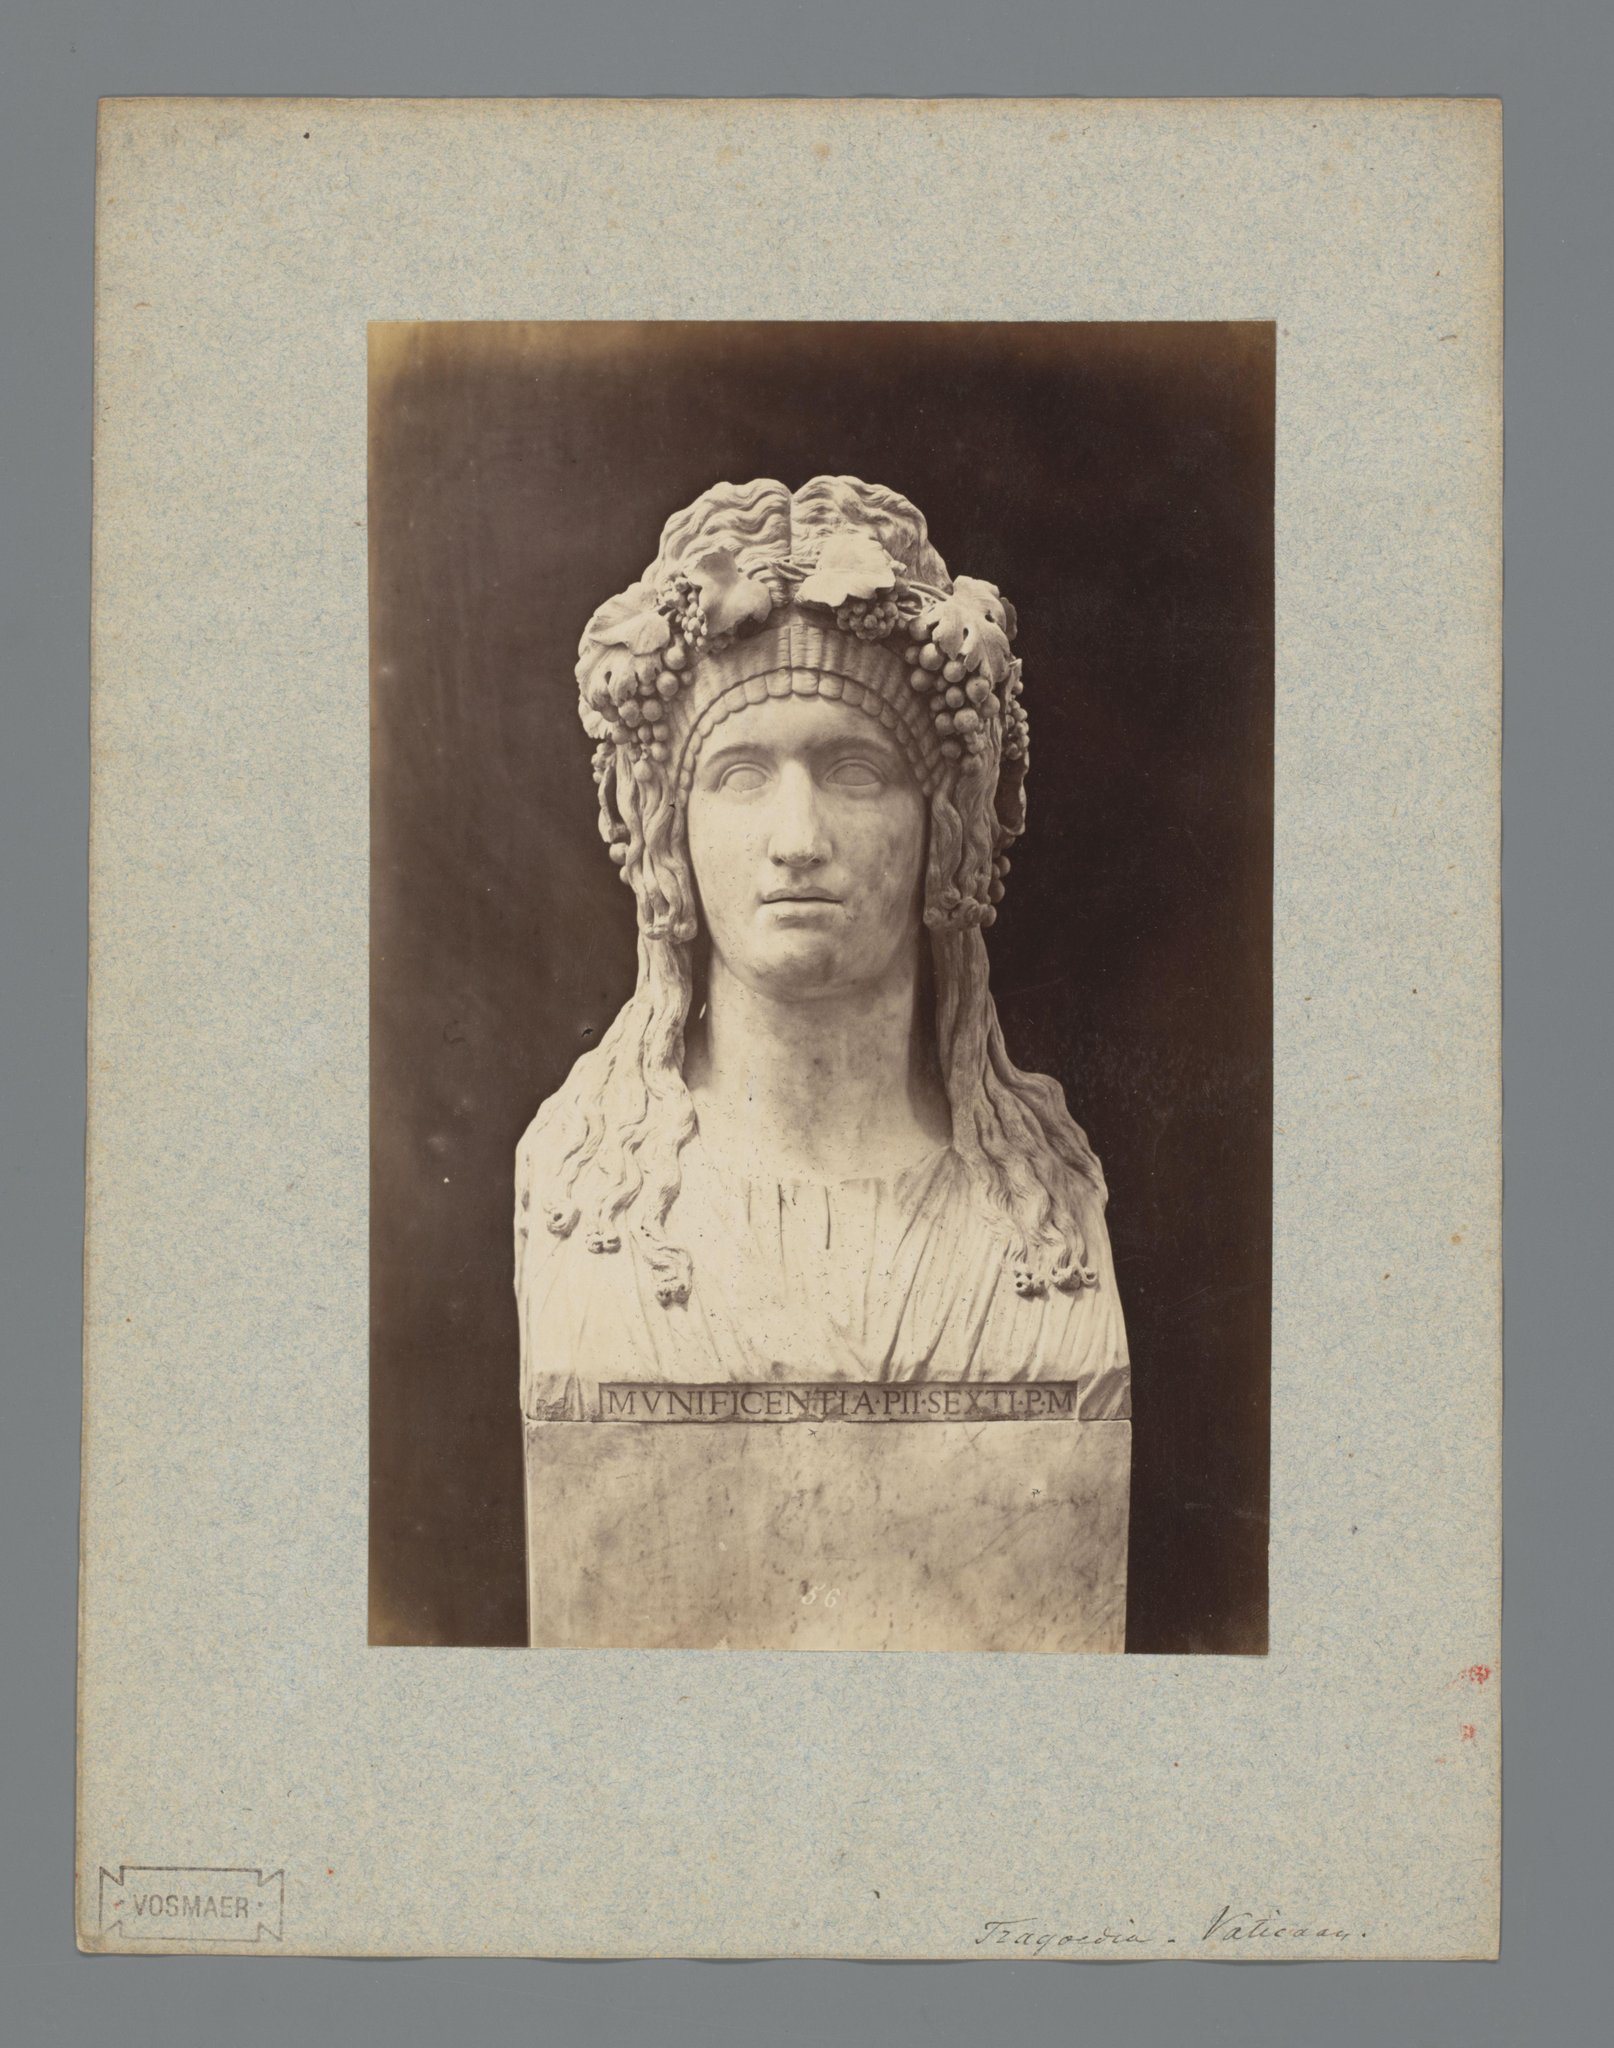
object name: photograph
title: Tragoedia - Vaticaan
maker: Anonymous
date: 1851-1890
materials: cardboard, paper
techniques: albumen print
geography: vatican city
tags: chest, bust, sculpture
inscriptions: number: ‘56’, collector's mark: ‘VOSMAER’